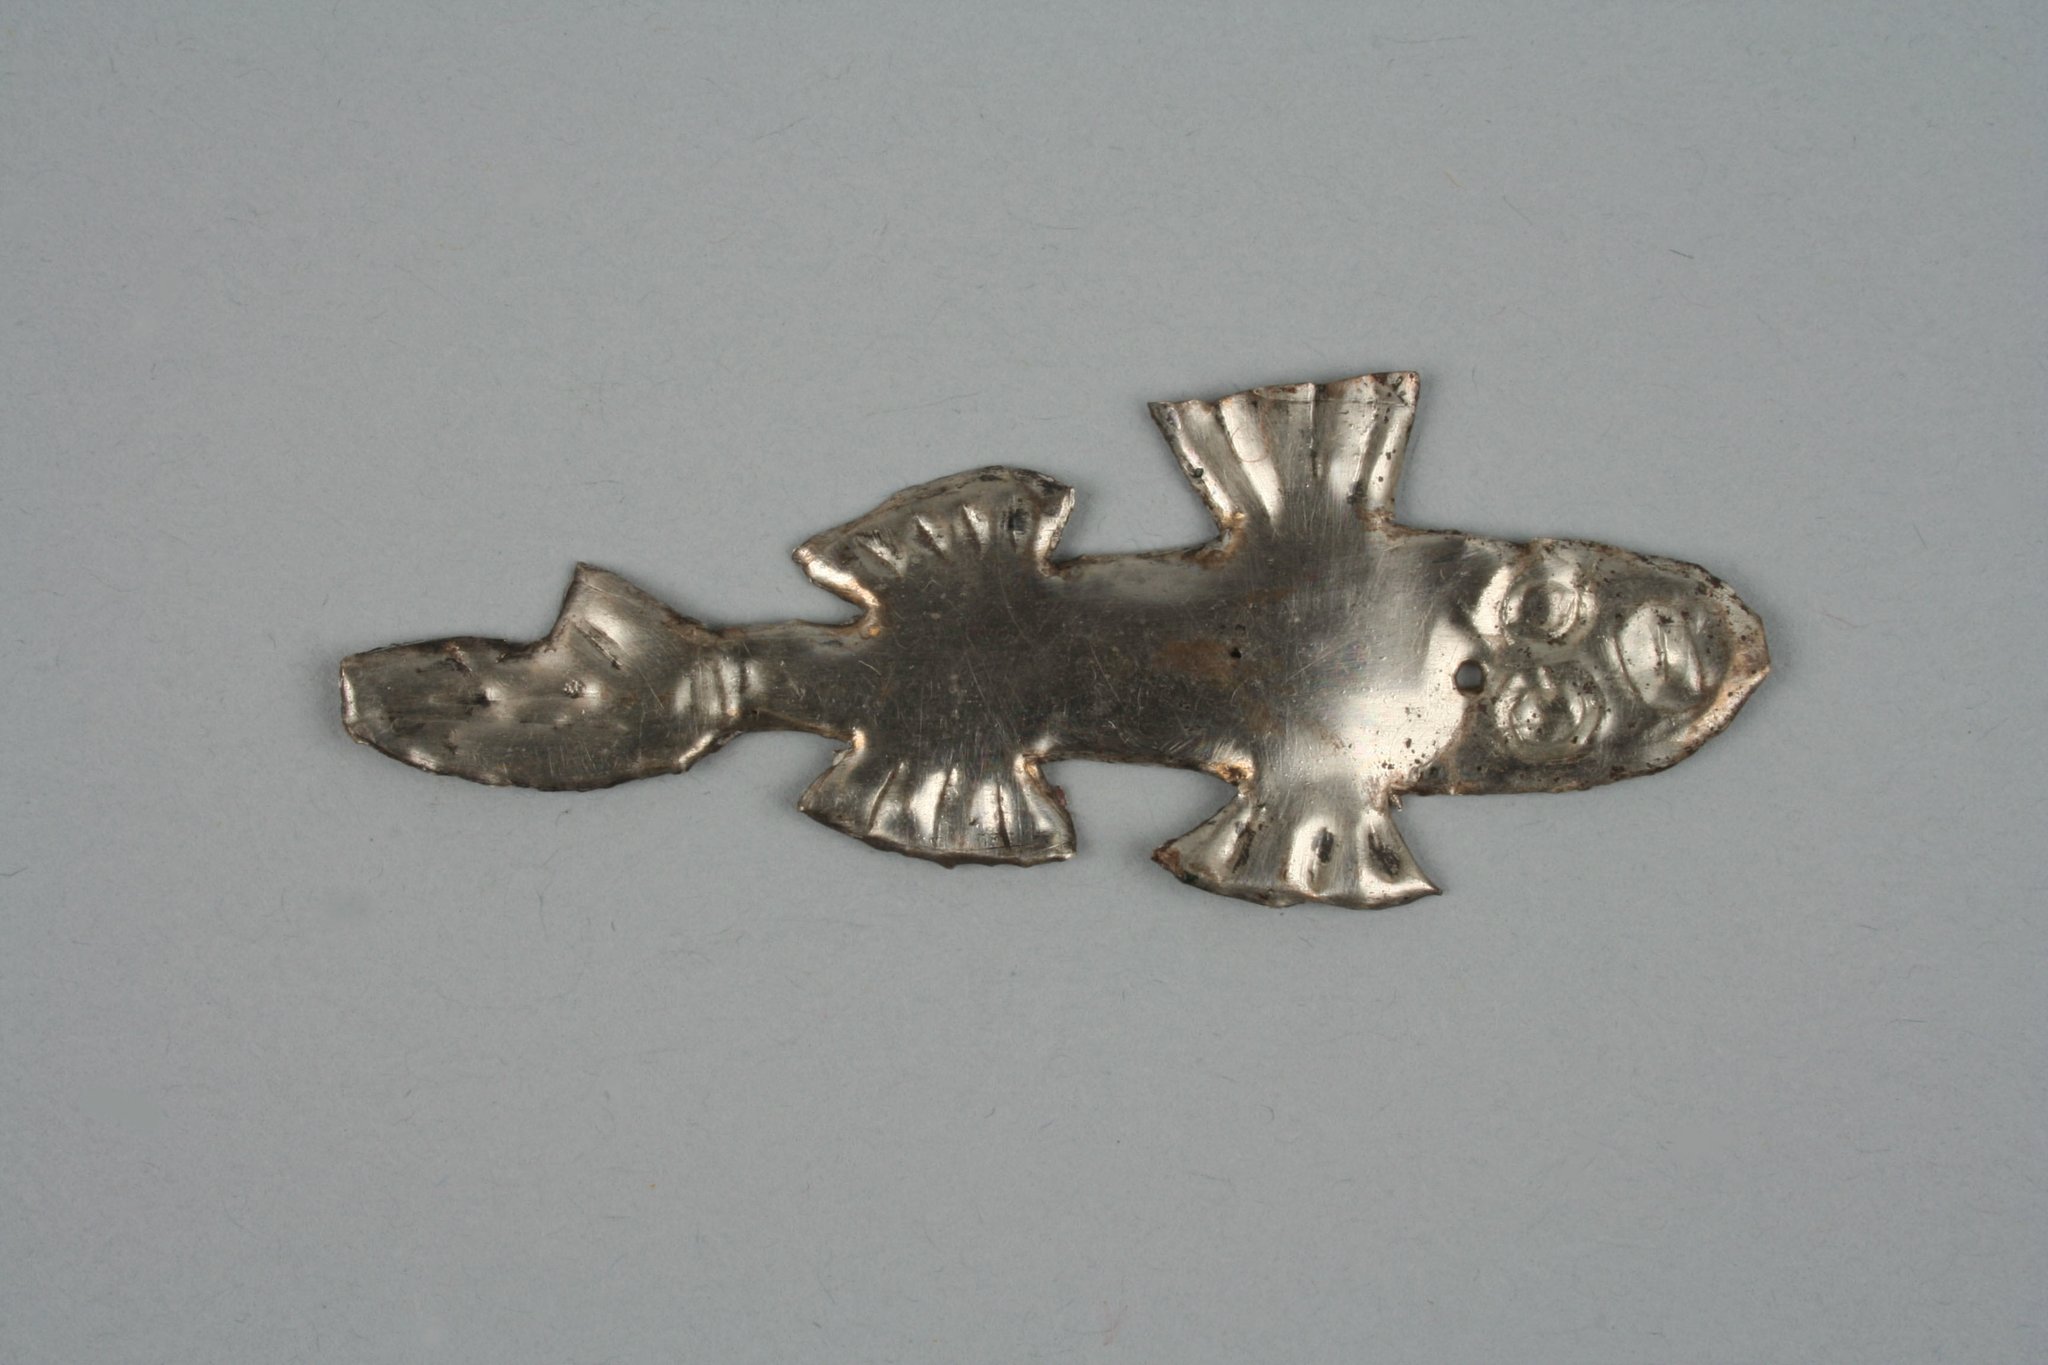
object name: ornament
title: Textile Ornament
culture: chimú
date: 1301-1500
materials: silver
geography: peru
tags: fish